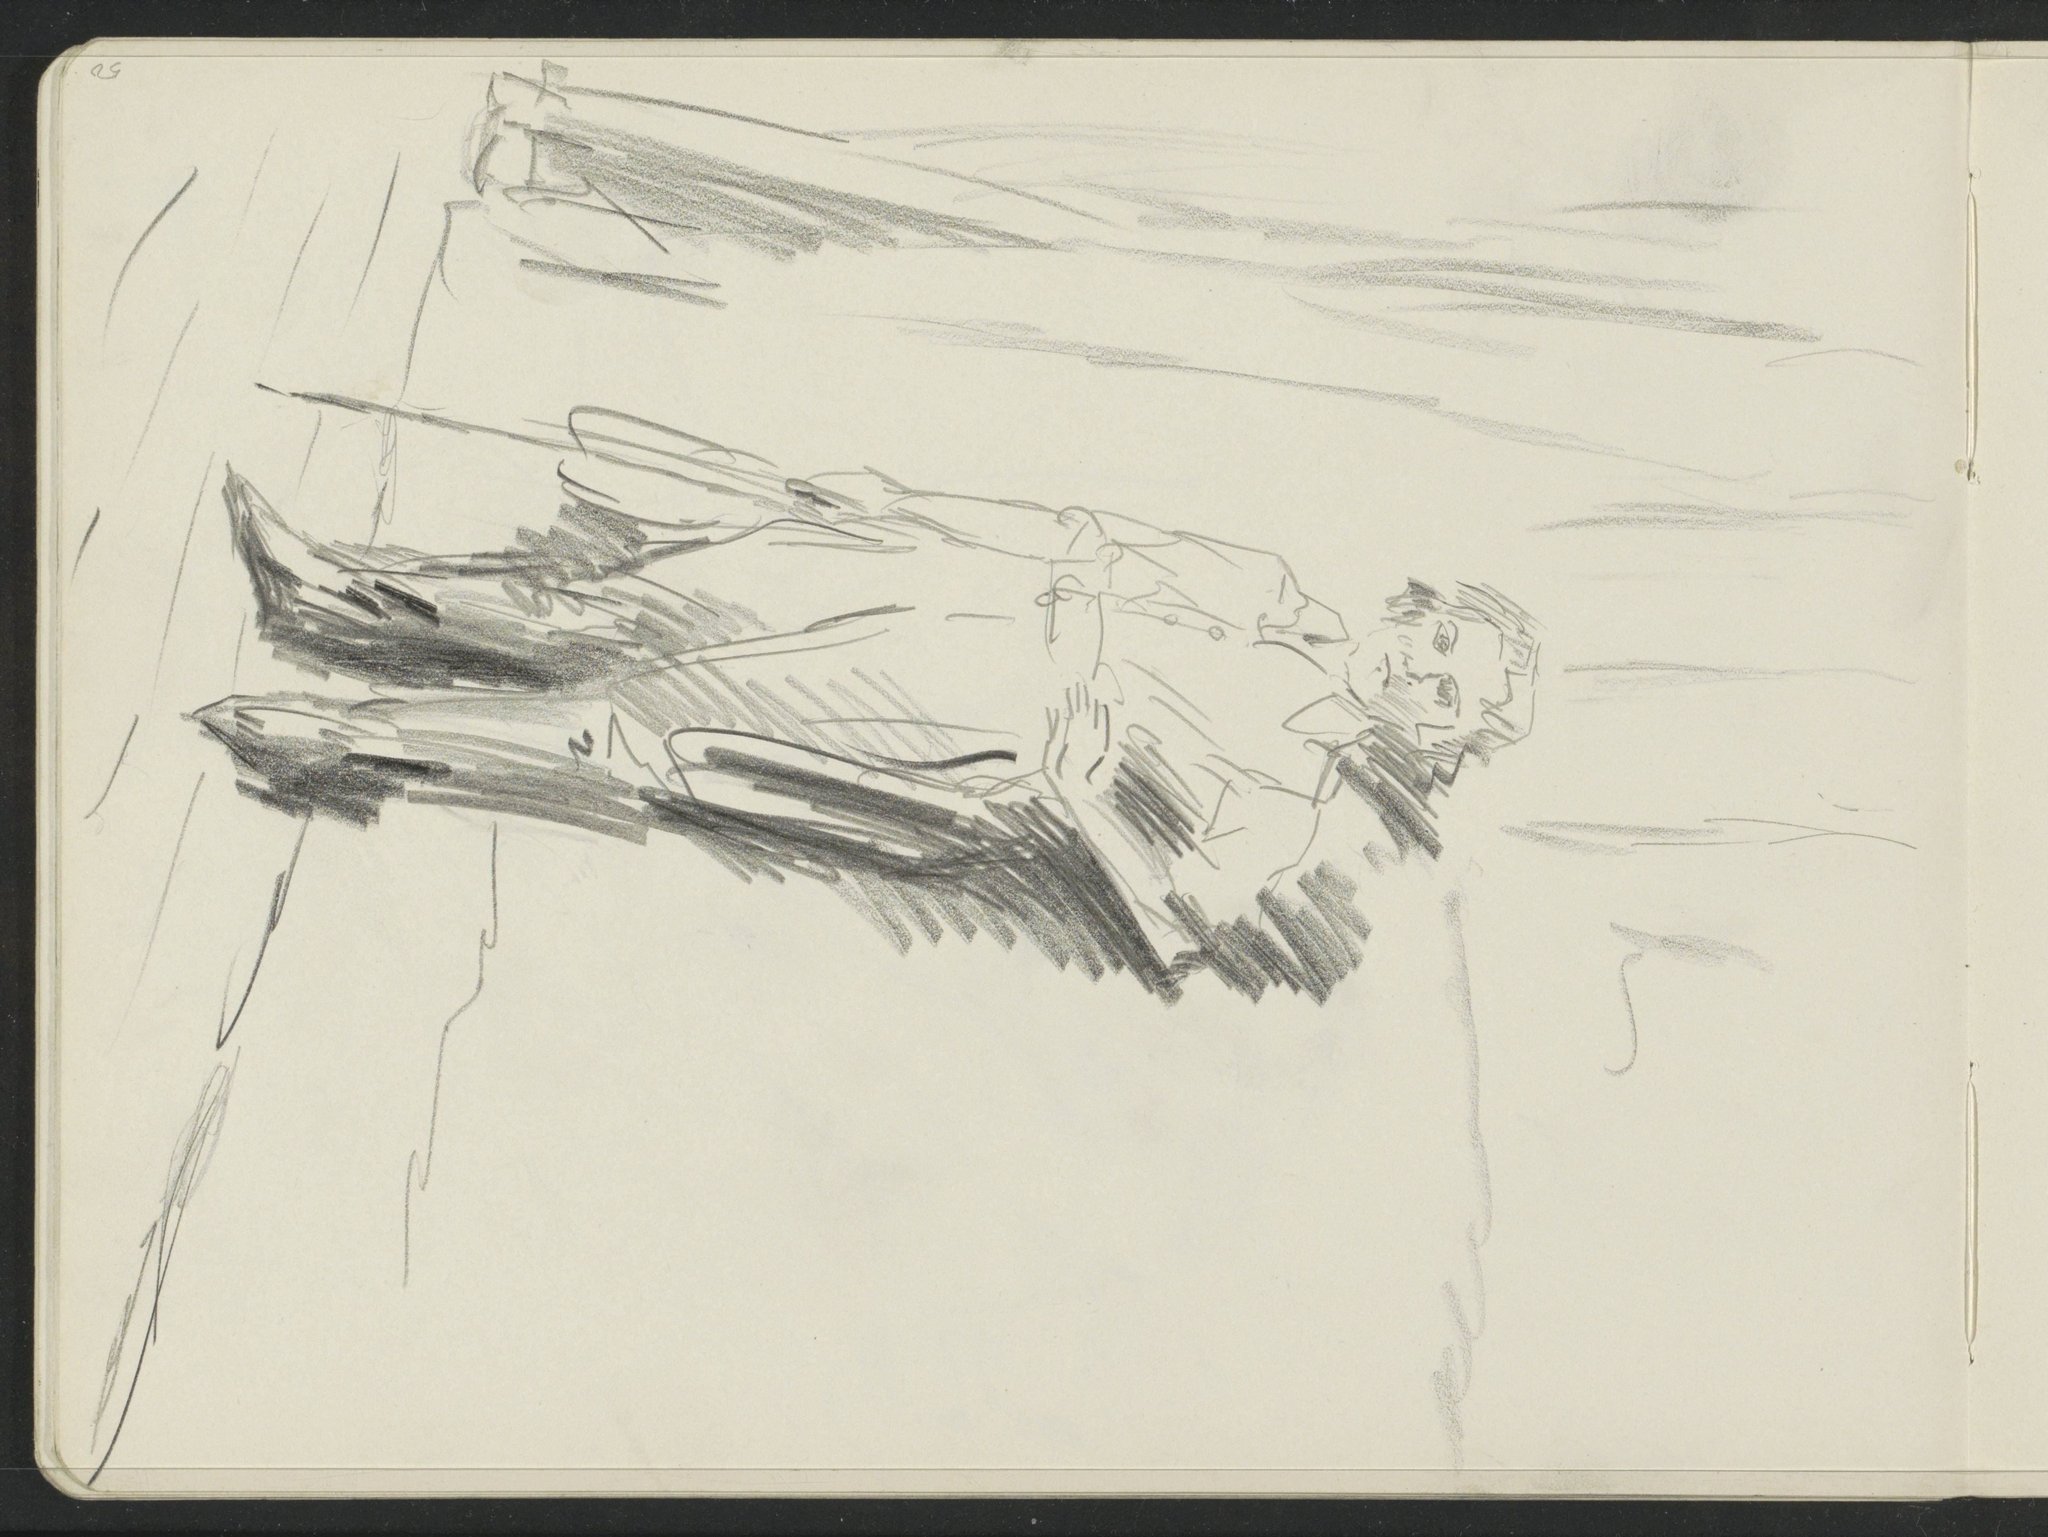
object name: sketchbook leaf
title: Staande figuur voor een wand of coulisse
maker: isaac israels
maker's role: draughtsman, painter, print maker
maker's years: 1865-1934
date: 1915-1934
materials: paper, pencil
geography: the hague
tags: standing figure, (military) uniforms, the stage and its equipment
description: Mogelijk in een uniform. Blad 13 verso uit schetsboek XVII met 31 bladen.